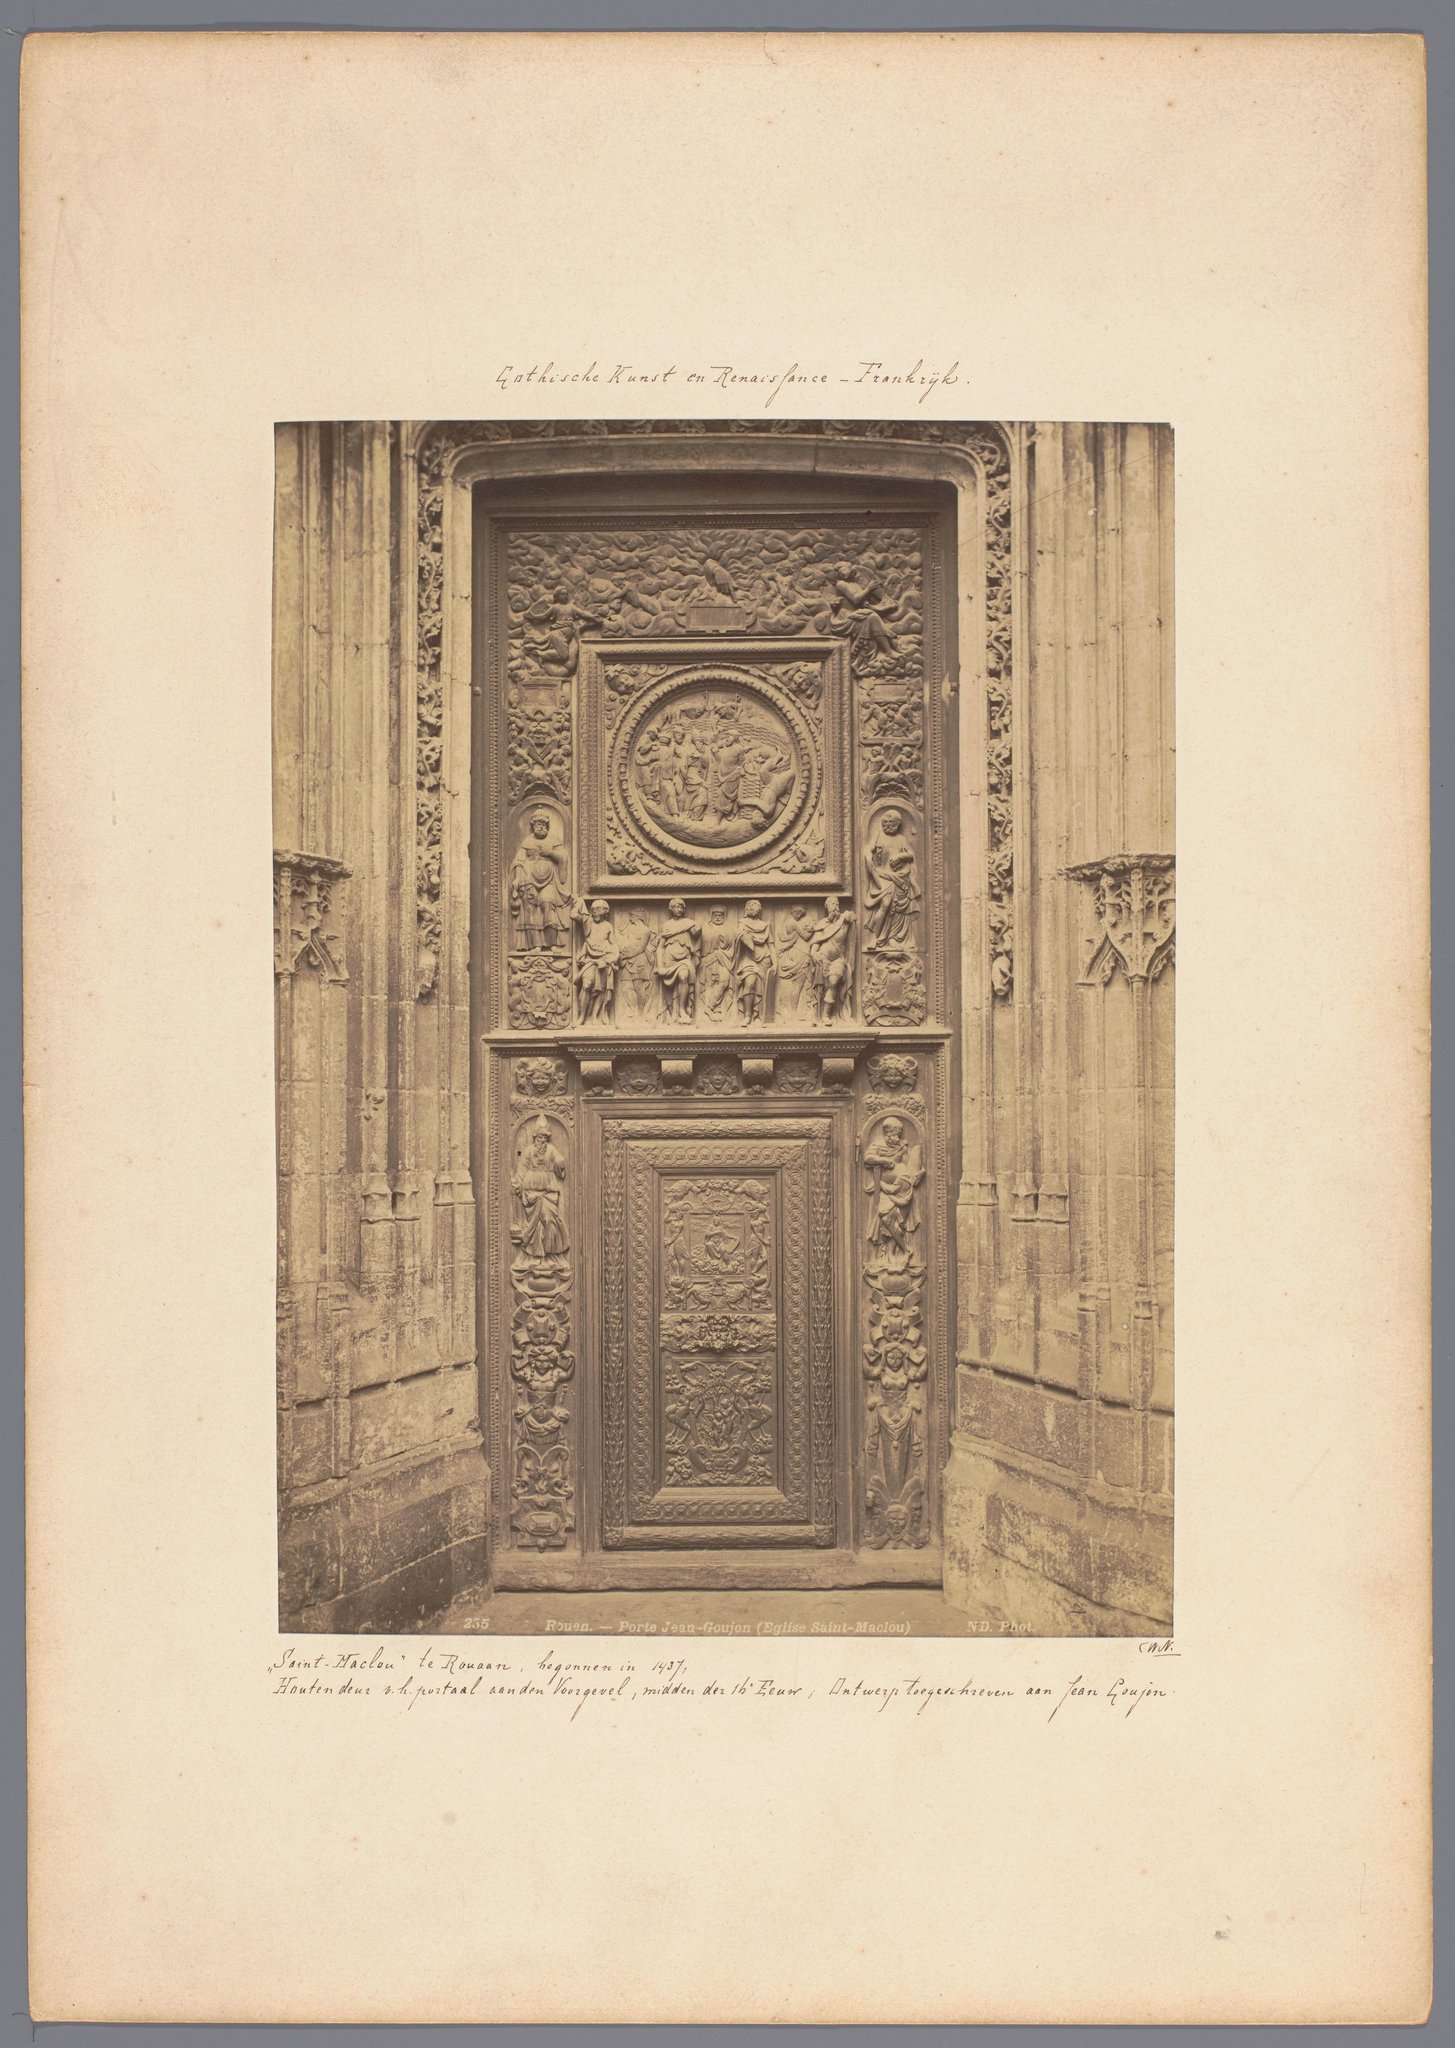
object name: photograph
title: Deur van de Saint-Maclou te Rouen door Jean Goujon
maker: étienne neurdein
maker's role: publisher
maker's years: 1832-1918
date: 1875-1900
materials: cardboard, photographic support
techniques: albumen print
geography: church of saint-maclou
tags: parts of church exterior and annexes: portal, door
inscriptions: inscription: ‘CWN.’, collector's mark: ‘INSTITUUT VOOR KUNST-NIJVERHEIDSONDERWIJS GABRIËL METSUSTRAAT No. 16 AMSTERDAM’, collector's mark: ‘KUNSTNIJVERHEIDSCHOOL QUELLINUS AMSTERDAM FRANS HALSSTRAAT 14.’, number: ‘235’, inscription: ‘Gothische Kunst en Renaissance - Frankrijk.’